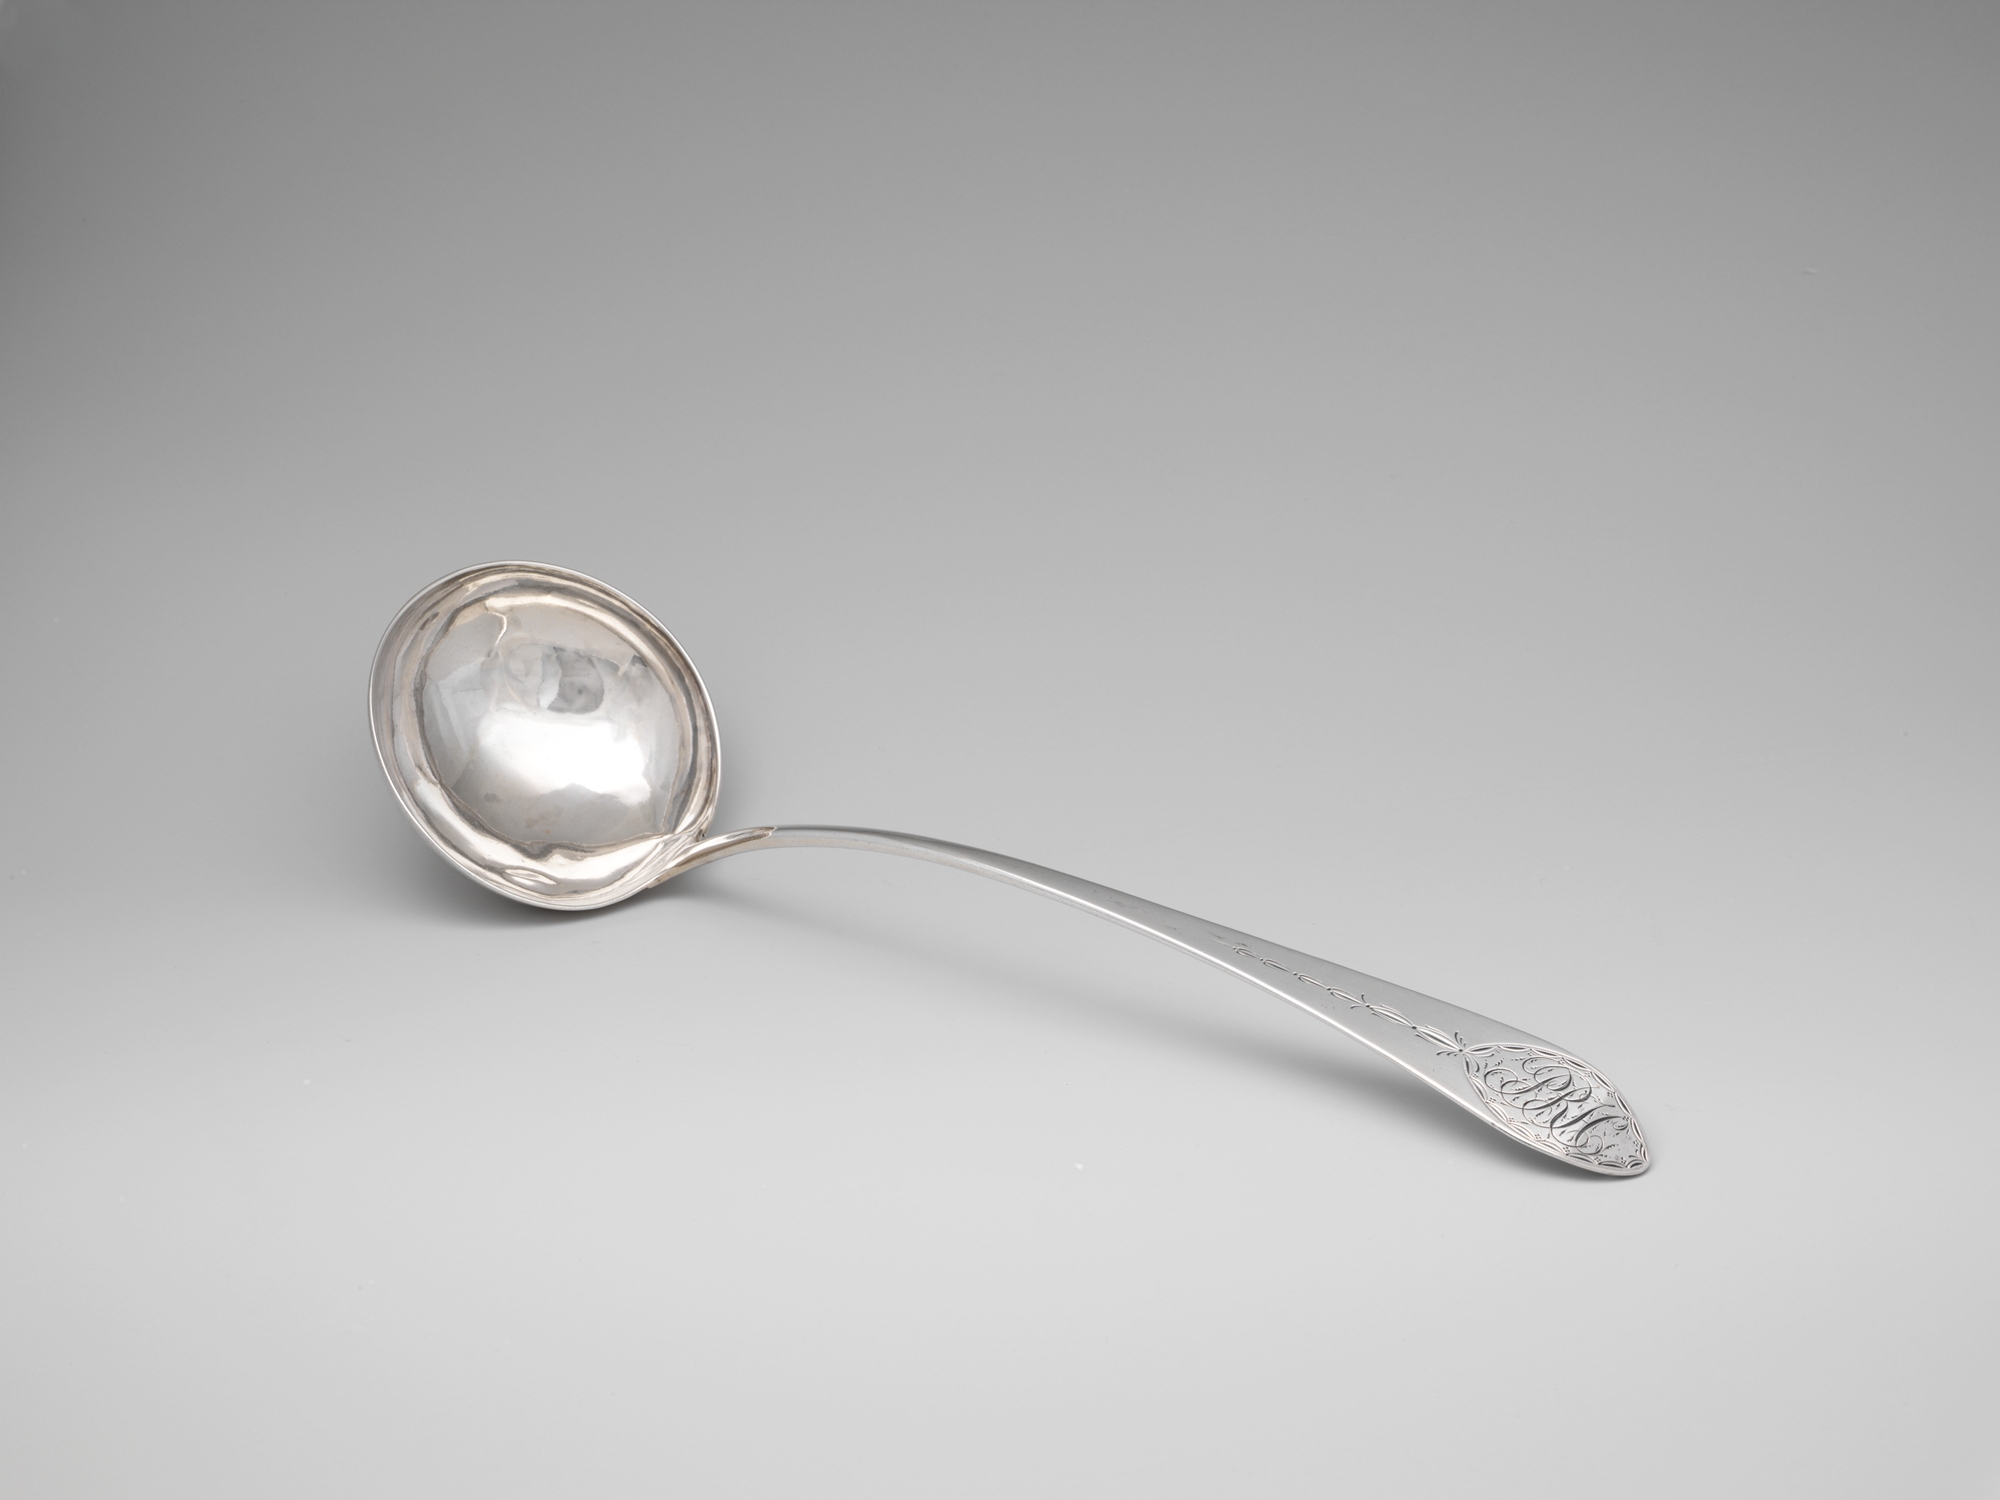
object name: ladle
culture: american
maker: john burger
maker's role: maker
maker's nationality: american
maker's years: 1783-1807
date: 1790-1800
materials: silver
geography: united states